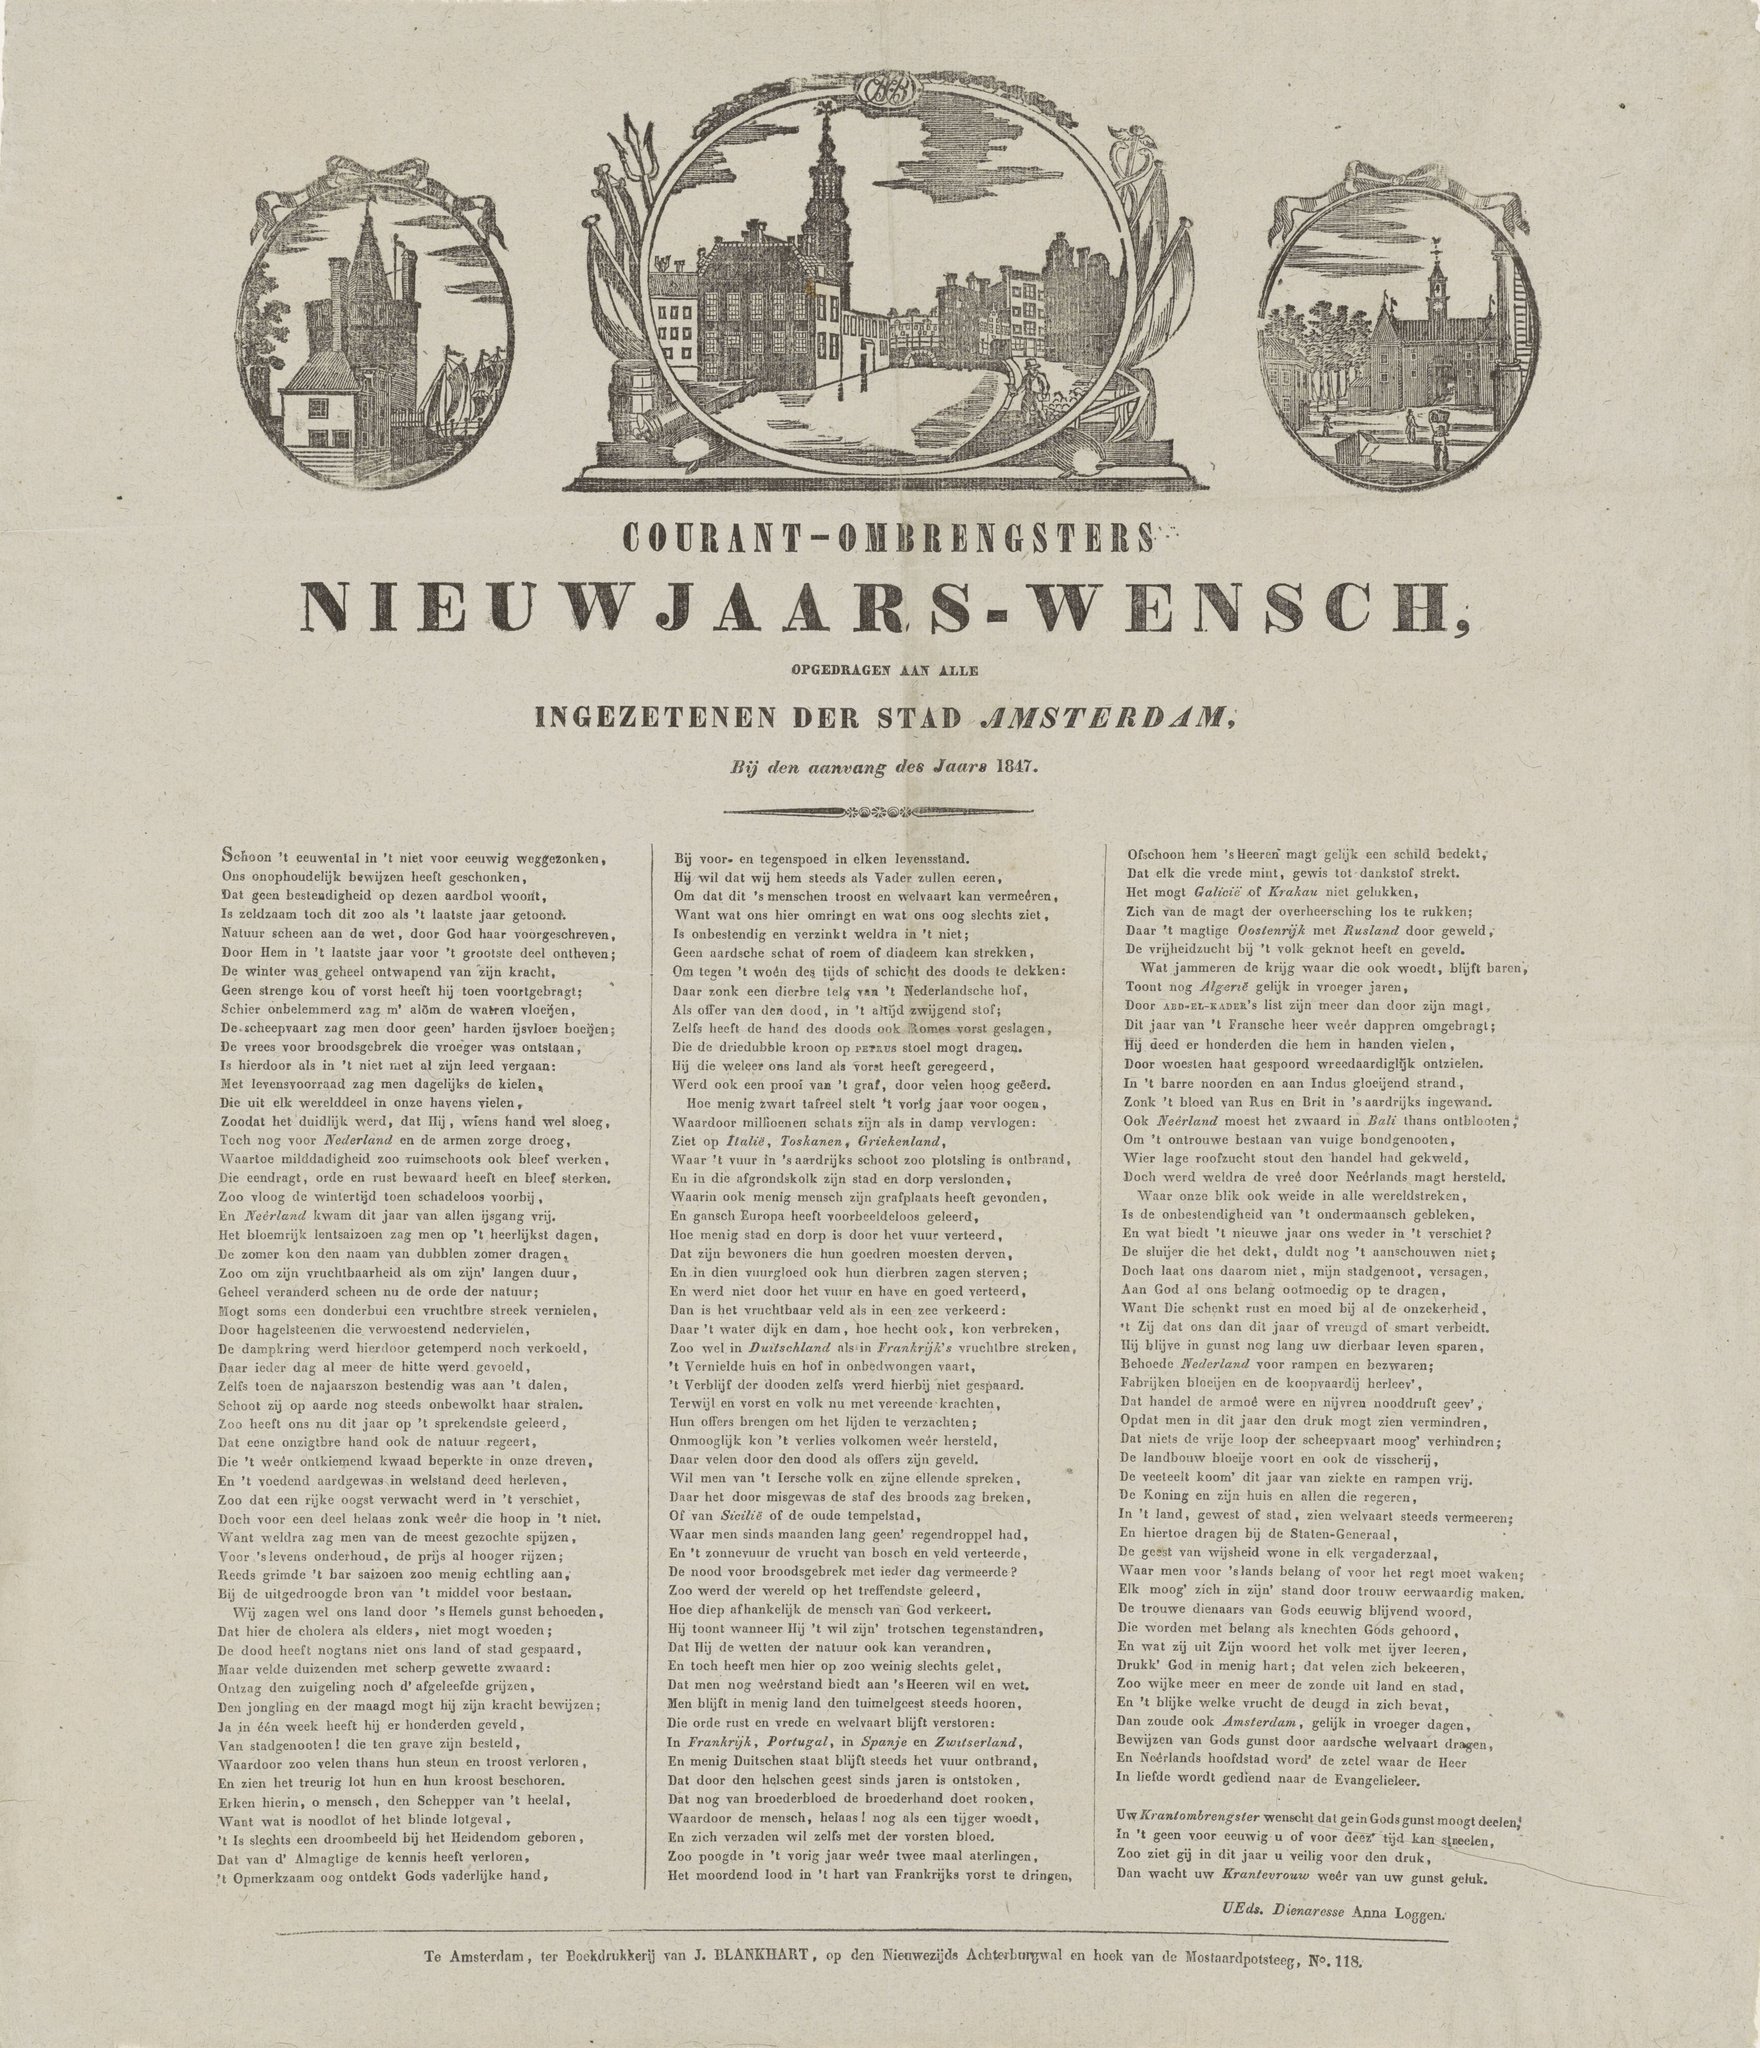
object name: new year card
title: Nieuwjaarswens van de Amsterdamse courantombrengers voor het jaar 1847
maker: Anonymous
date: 1846-1847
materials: paper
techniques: letterpress printing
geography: amsterdam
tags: delivery (of newspaper), street, amsterdam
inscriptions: collector's mark: Lugt 2228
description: Nieuwjaarswens namens de ombrengers van couranten (krantenbezorgers) te Amsterdam voor het jaar 1847. Bovenaan drie medaillons met centraal een gezicht op het Singel bij de Munt met op de kade een krantenbezorger, links de Schreierstoren, rechts de Leidsepoort. Onderaan een gedicht in vier kolommen. Van de courantombrengster: Anna Loggen.